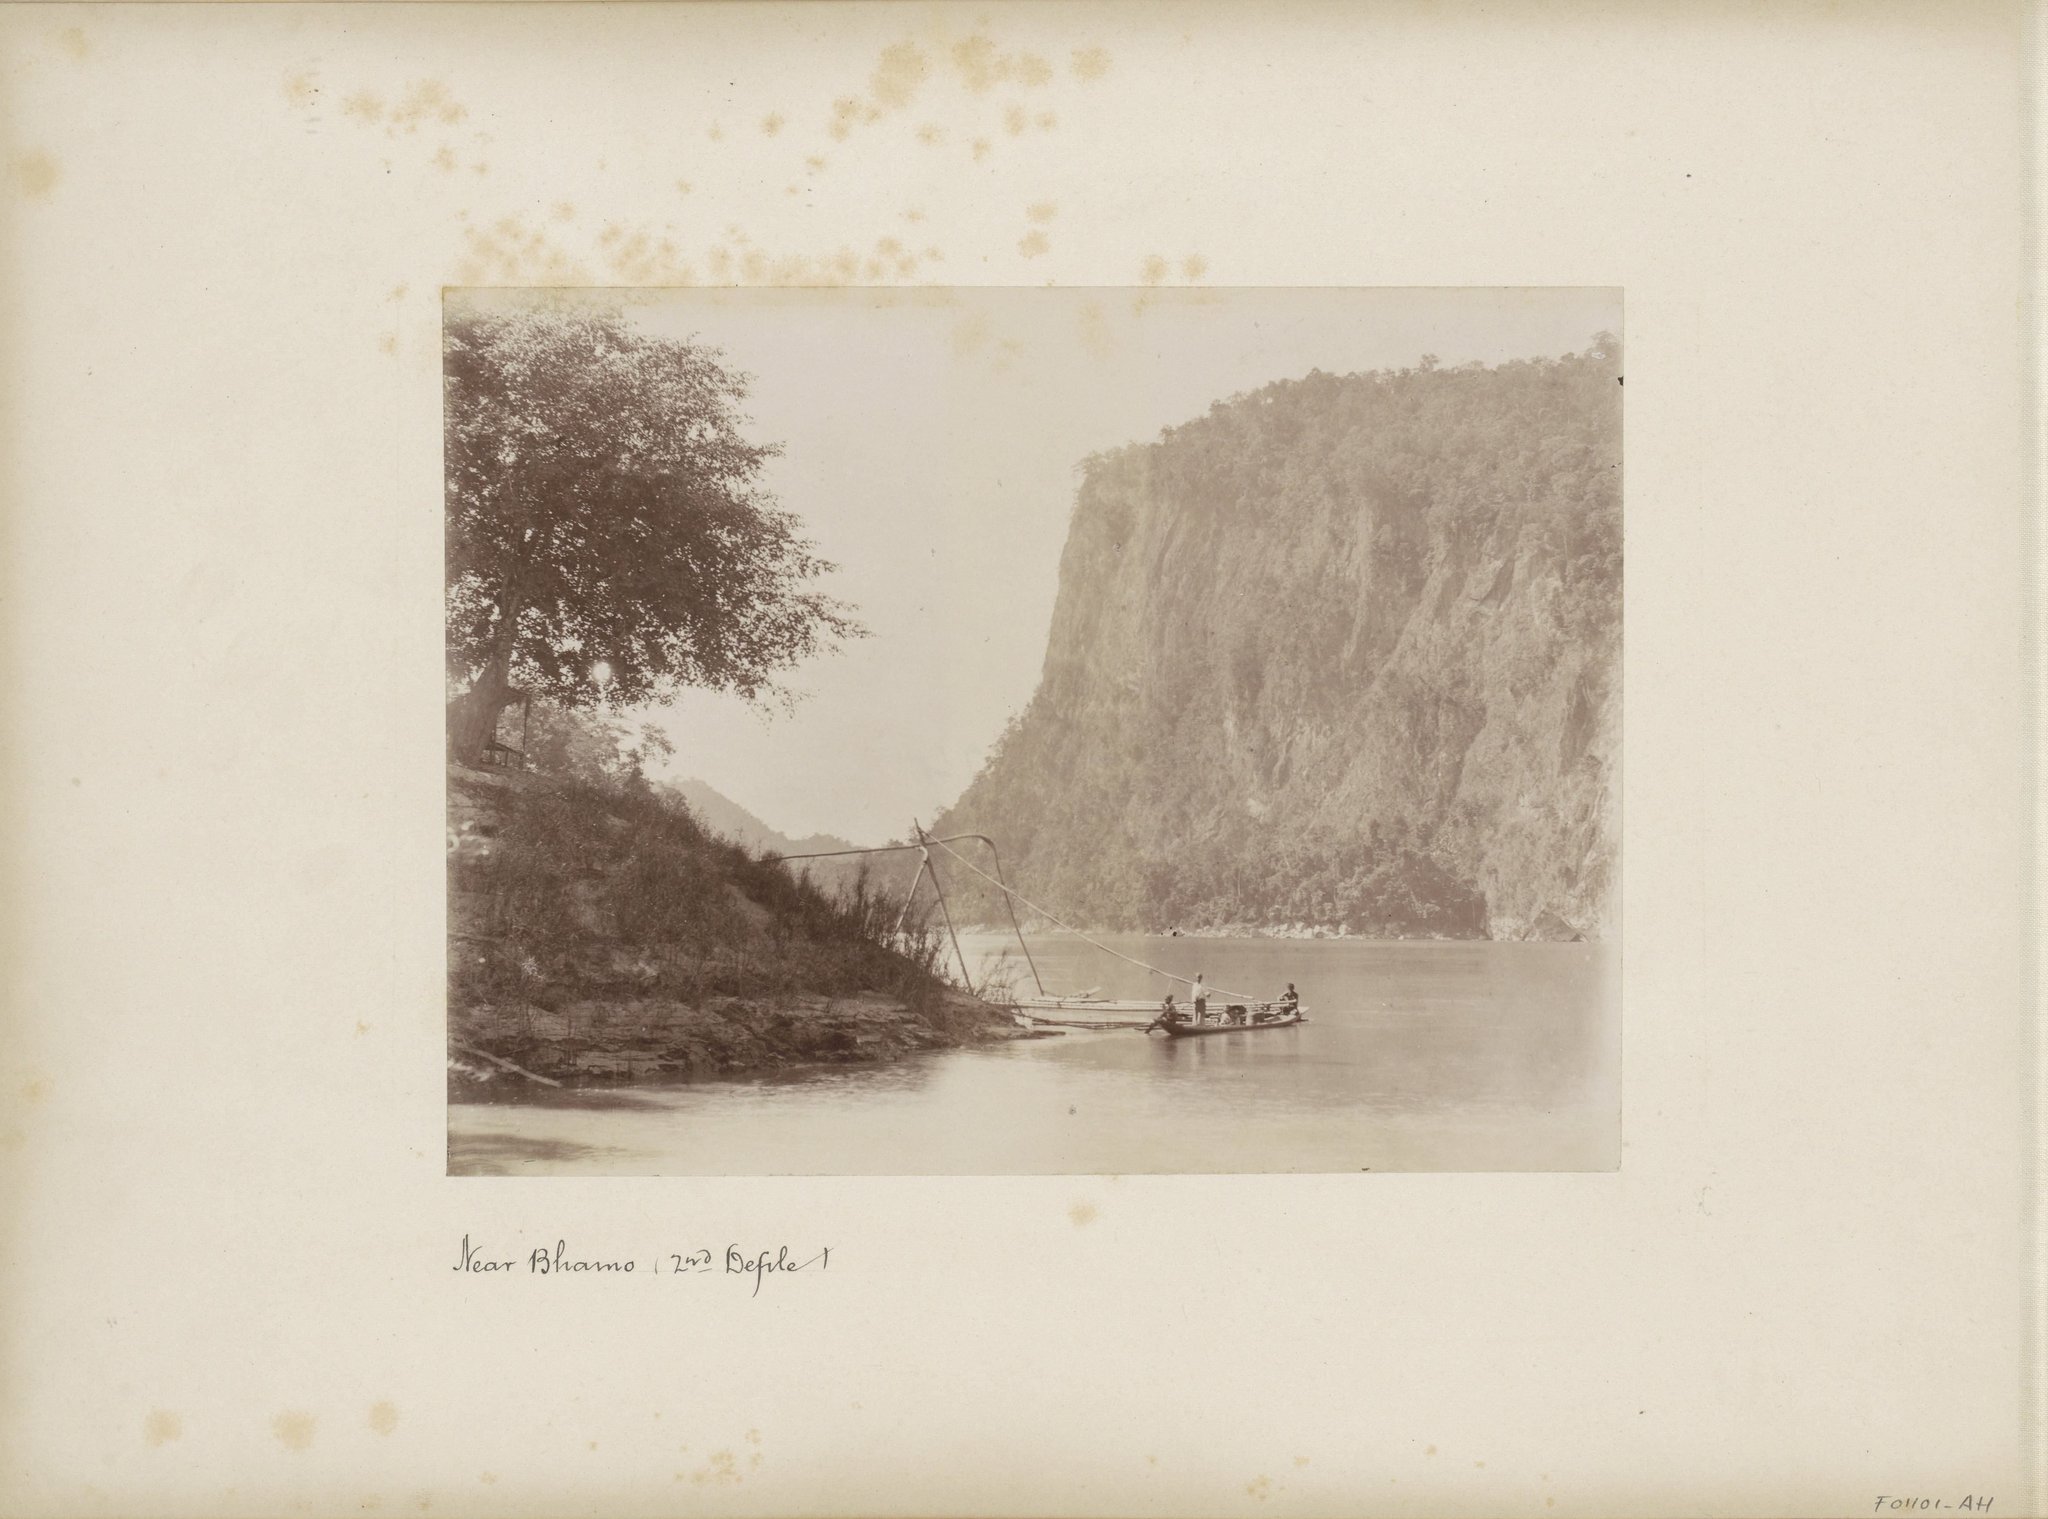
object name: photograph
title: Boat on a river in a mountain gorge near Bhamo, Myanmar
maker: Anonymous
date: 1885-1886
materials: cardboard, paper, photographic support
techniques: albumen print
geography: bhamo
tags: ravine, chasm, abyss, canyon, river (+ landscape with figures, staffage)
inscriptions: caption: ‘Near Bhamo (2nd Defile)’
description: Onderdeel van Reisalbum met foto's van bezienswaardigheden in Birma.